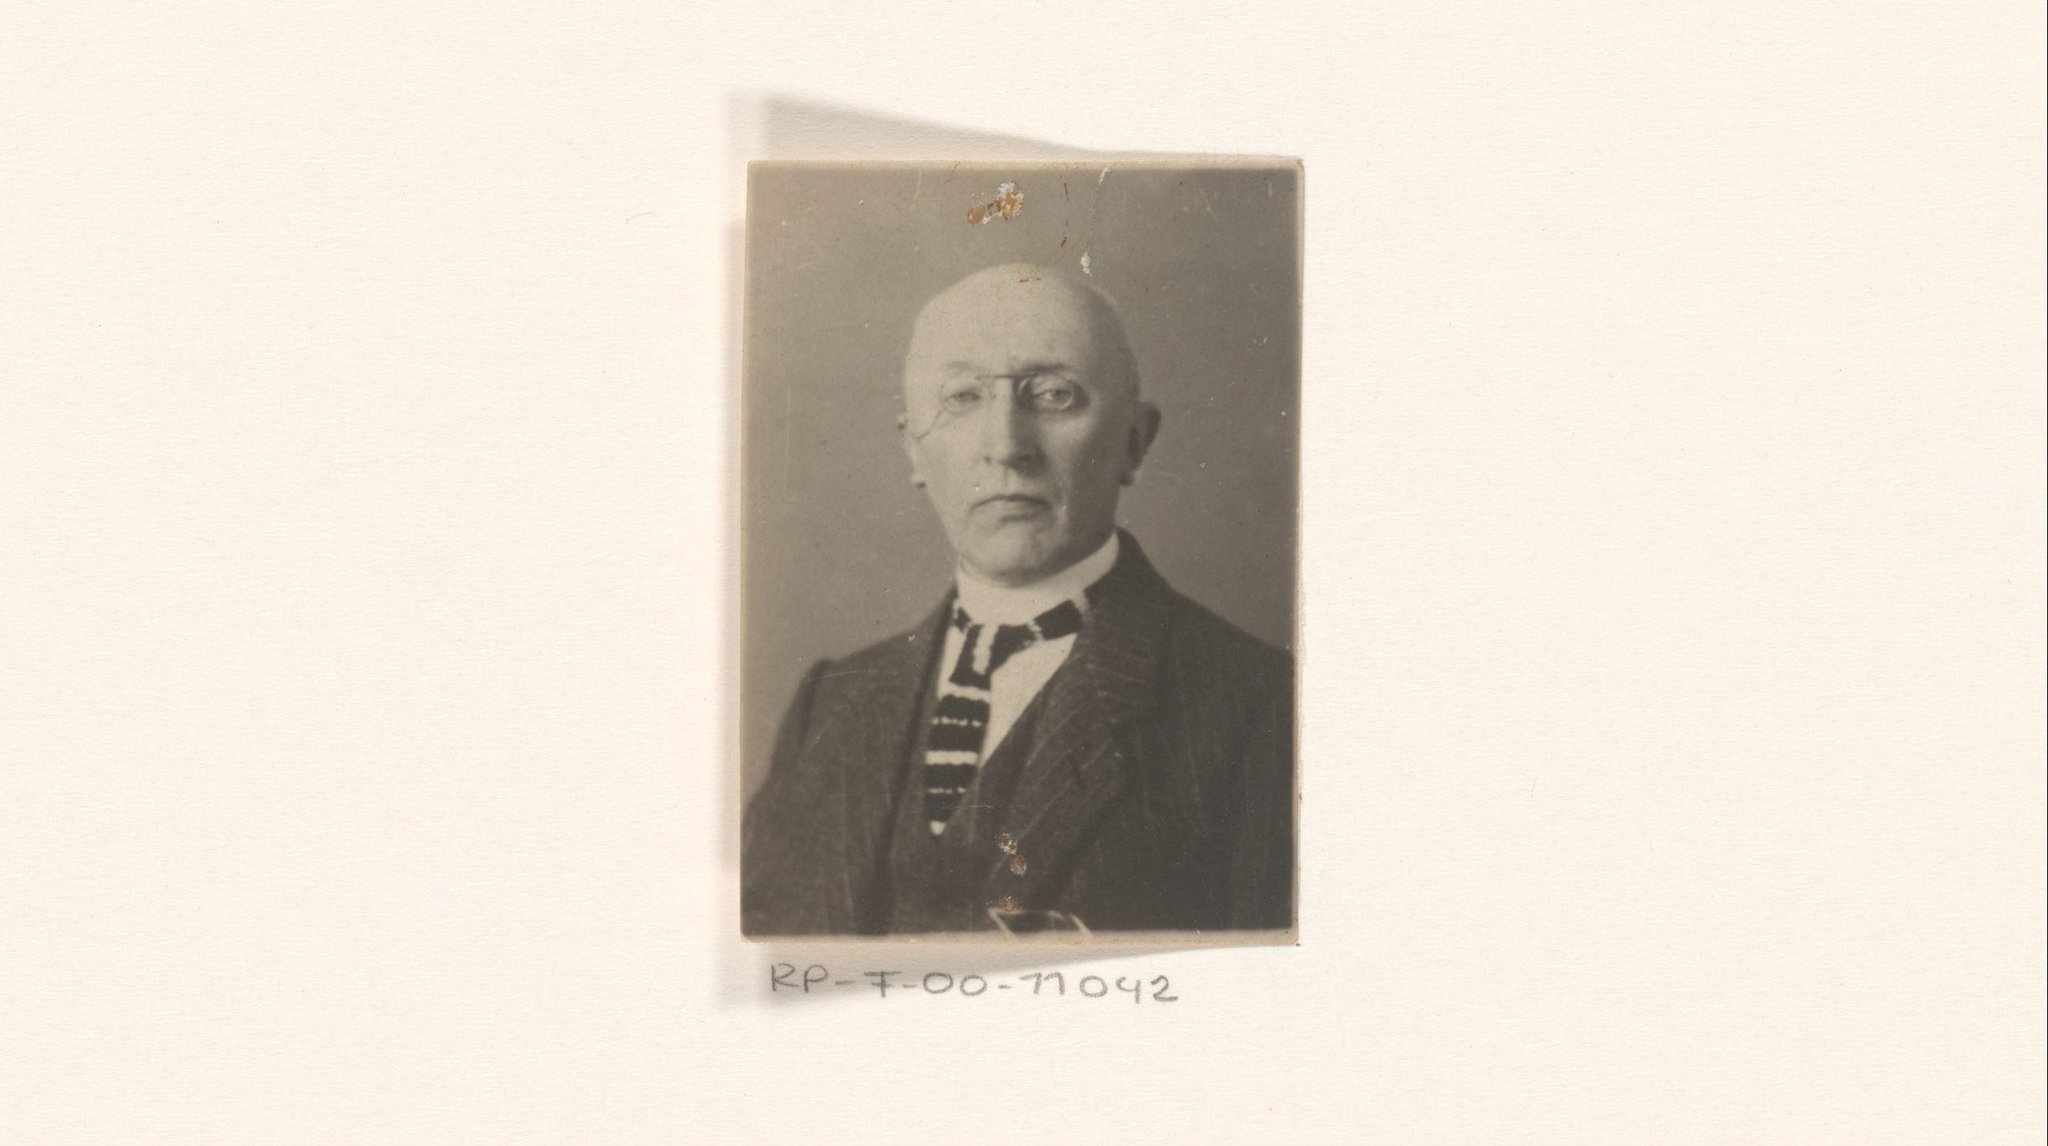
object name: photograph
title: Portret van Antony Cornelis Christiaan de Vletter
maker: Anonymous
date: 1900-1935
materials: photographic support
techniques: gelatin silver print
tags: the hague, portrait of a writer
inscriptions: collector's mark: Lugt 2228a, annotation: ‘deVletter’